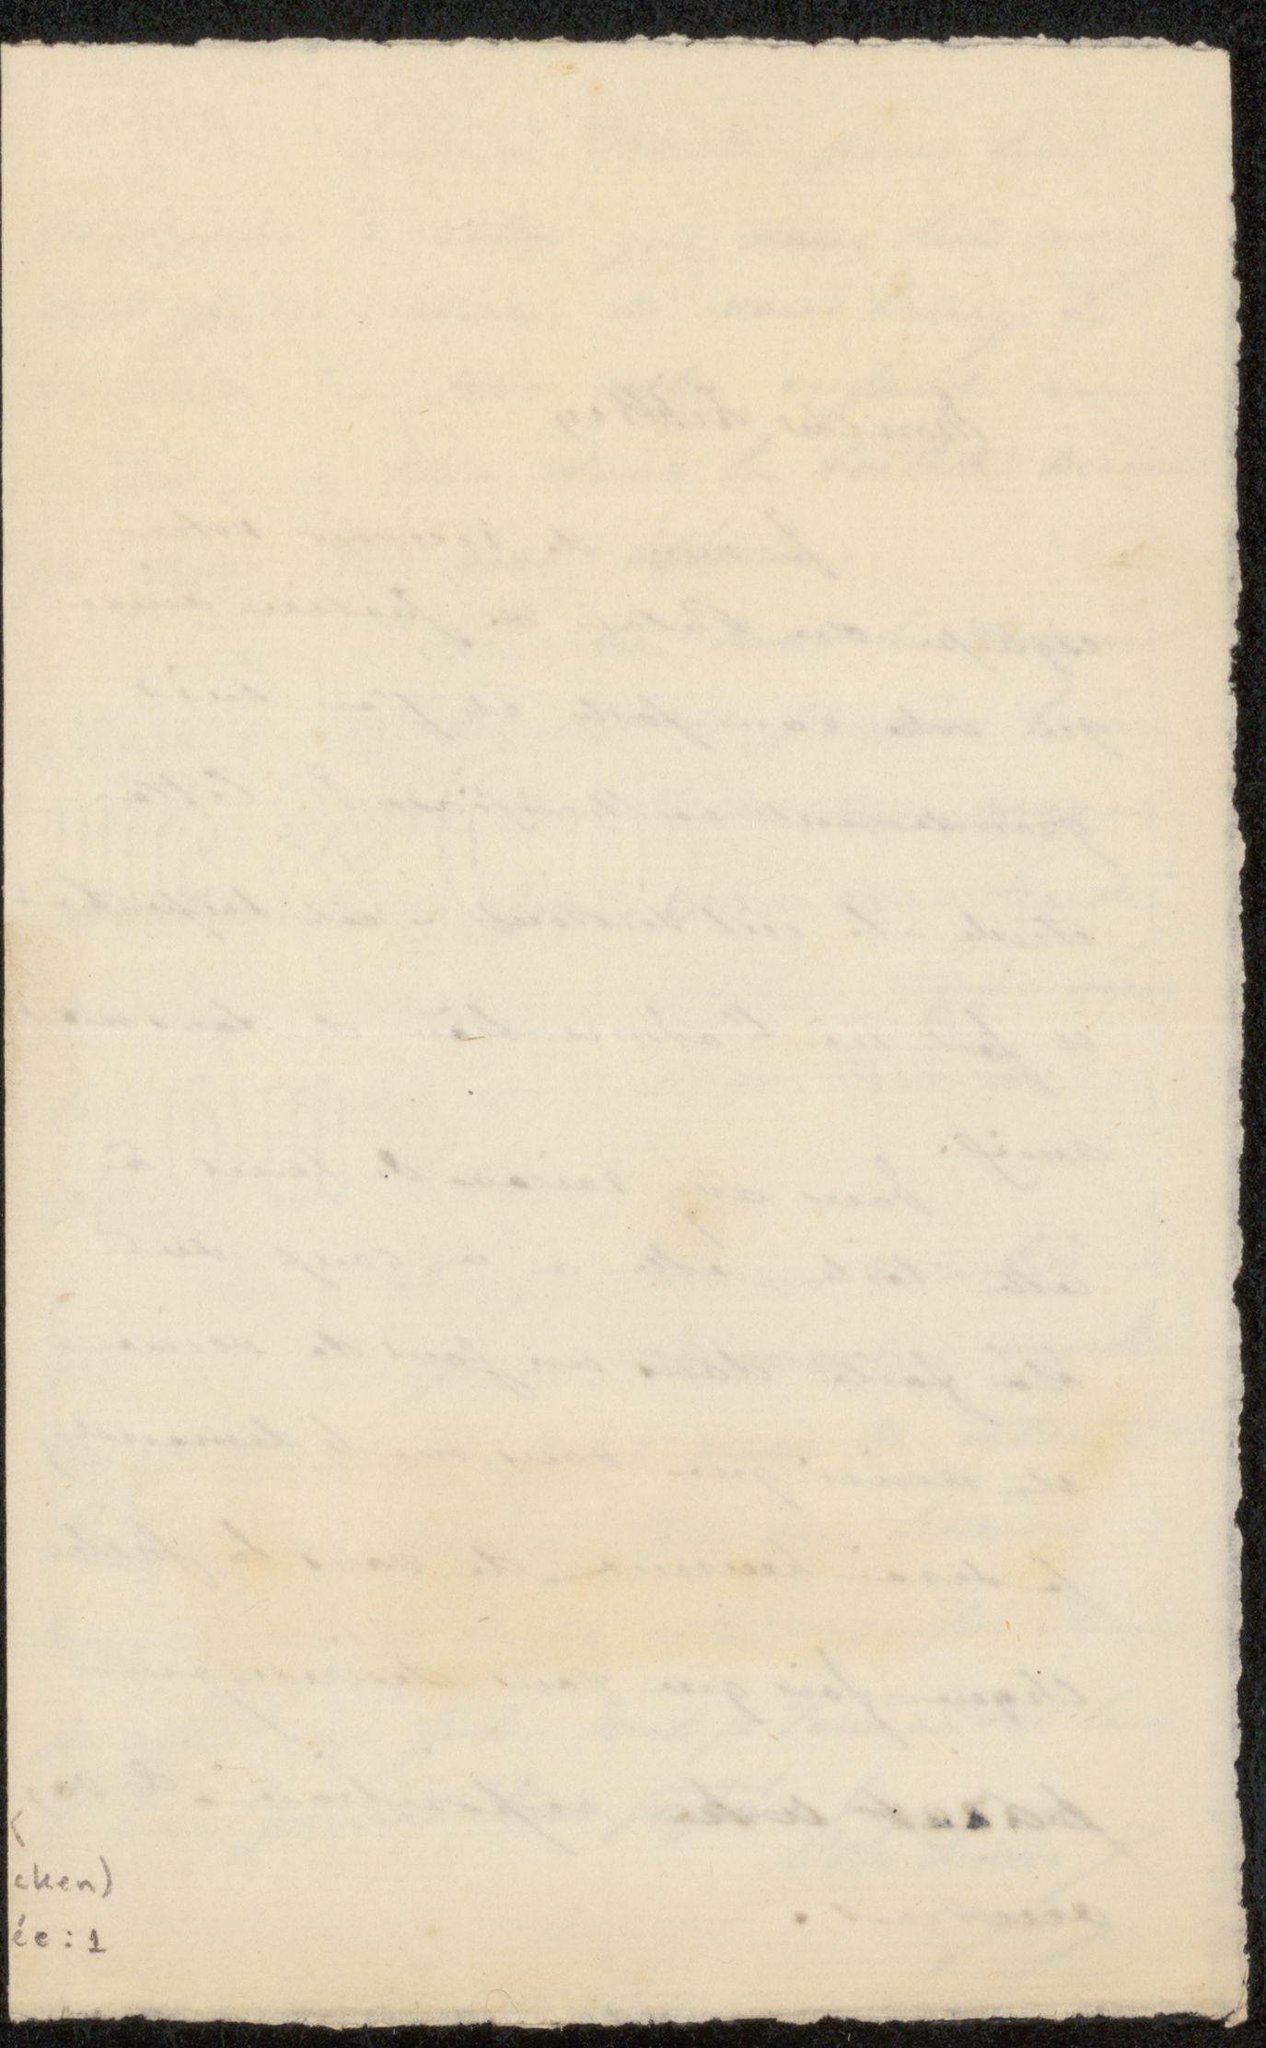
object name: letter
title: Brief aan Philip Zilcken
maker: jules destrée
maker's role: politician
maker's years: 1863-1936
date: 1873-1930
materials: ink, paper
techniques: pen, writing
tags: charles destrée, the hague, painter, draughtsman, philip zilcken, the graphic arts, exhibition ~ art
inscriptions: collector's mark: ‘RPK’